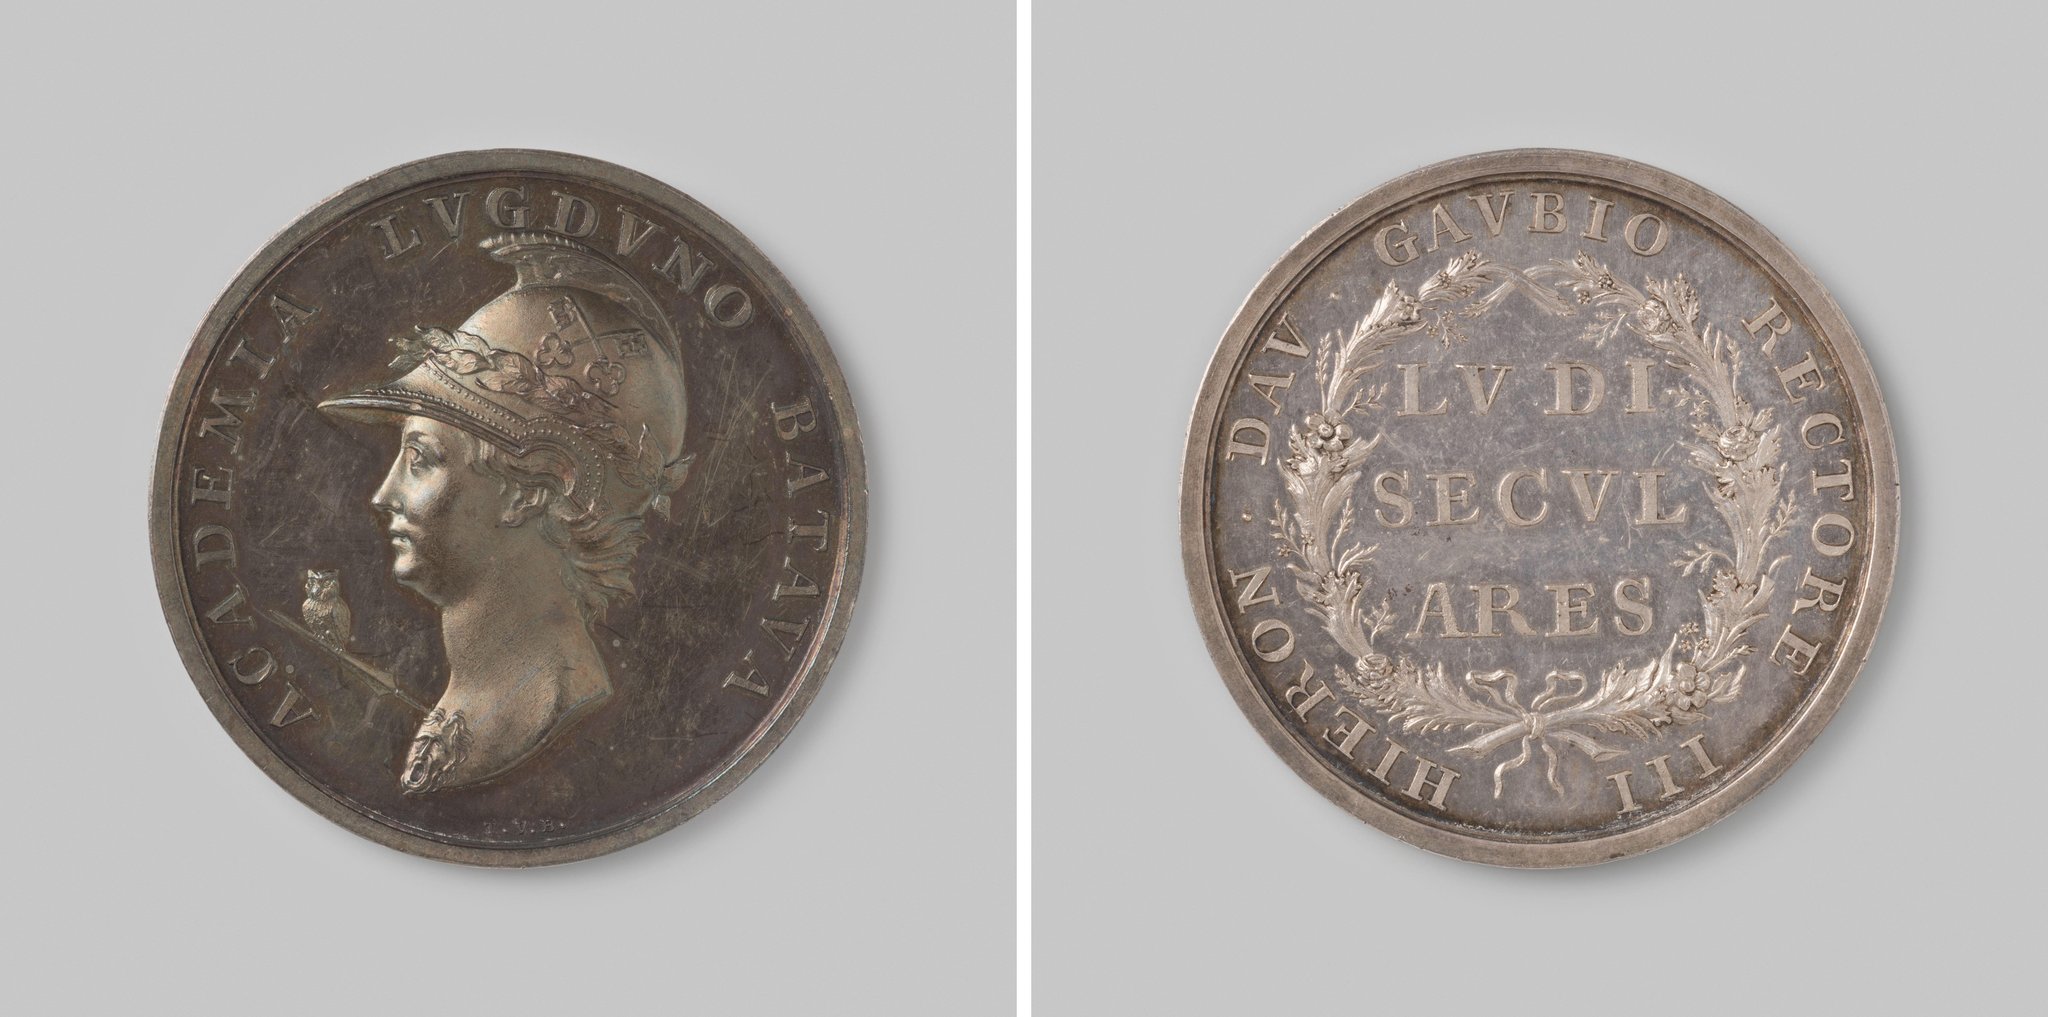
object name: history medal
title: Tweehonderdjarige herdenking van de oprichting van de Hoogeschool te Leiden 1775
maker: theodorus everardus van berckel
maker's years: 1708-1770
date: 1775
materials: silver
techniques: pressing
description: Zilveren penning, op de voorzijde het portret van Minerva naar links met gekruisde sleutels op haar helm, over haar schouder een speer waarop een uil, met omschrift, op de keerzijde drie regels tekst tussen twee samengestrikte bloemranken, met omschrift.